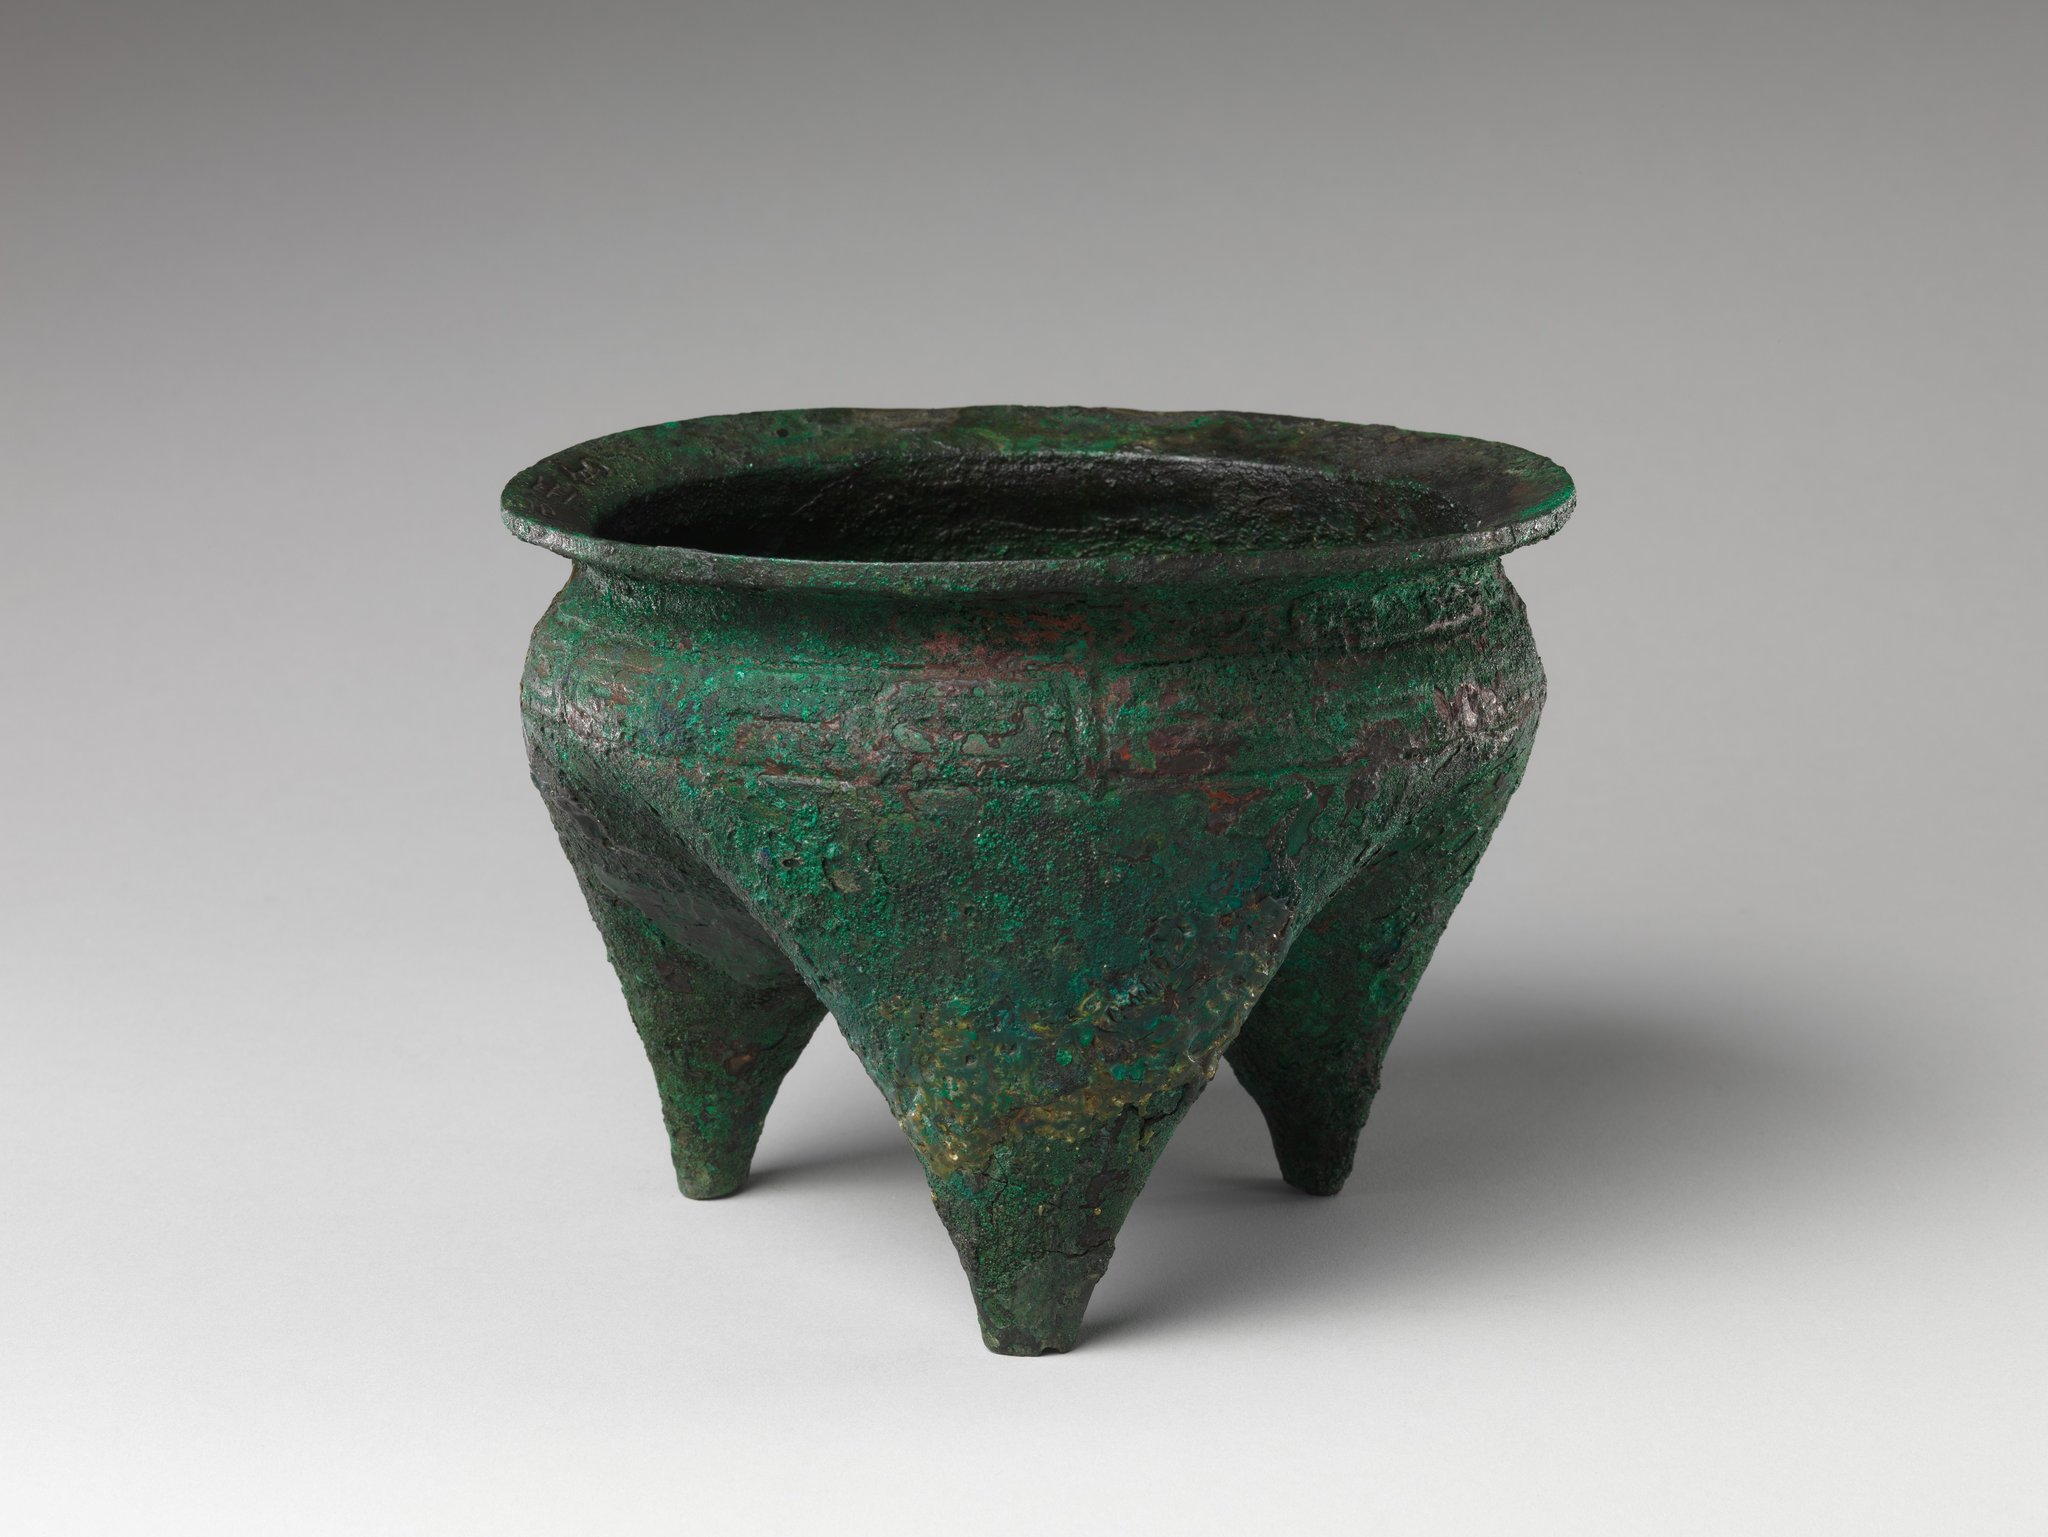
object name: cauldron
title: Lobed cauldron (li) in ancient style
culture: chinese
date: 1801-1900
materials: bronze, patina